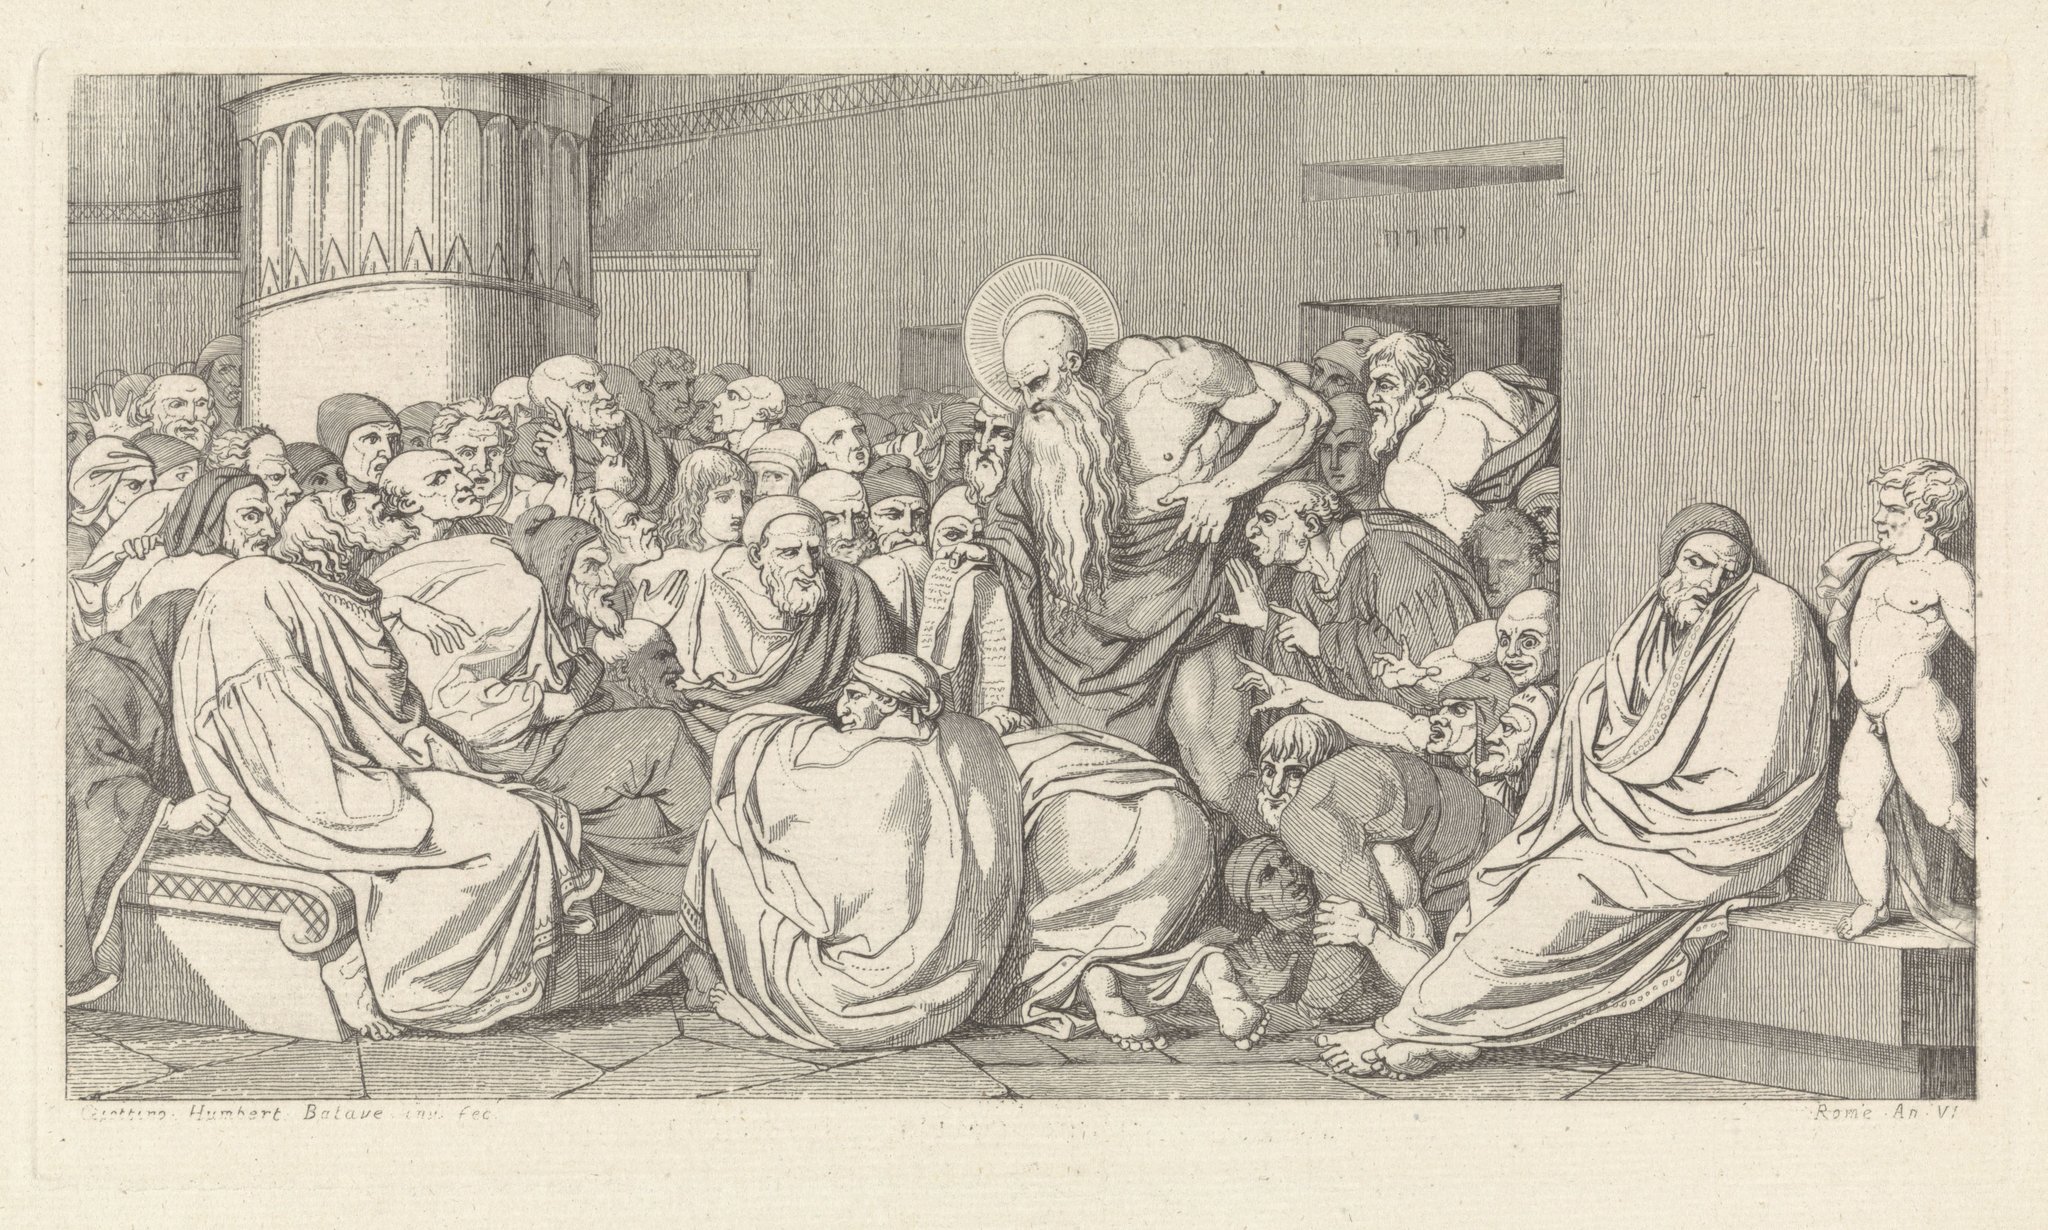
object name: print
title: Jeremia voor de tempel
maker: david pièrre giottino humbert de superville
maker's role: draughtsman, painter, print maker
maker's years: 1770-1849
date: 1796-1849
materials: paper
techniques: etching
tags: jeremiah condemning idolatry (jeremiah 2-6), other scenes ~ the book of jeremiah (with book chapter:verse)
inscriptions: collector's mark: Lugt 2228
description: Jeremia, met lange baard en aureool, spreekt de mensen om hem heen toe. Achter hem de tempelpoort met daarboven een inscriptie in Hebreeuws. De voorstelling verbeeldt de eerste verzen van hoofdstuk zeven in het Bijbelboek Jeremia. Wellicht is de voorstelling ook bedoeld als spotprent.